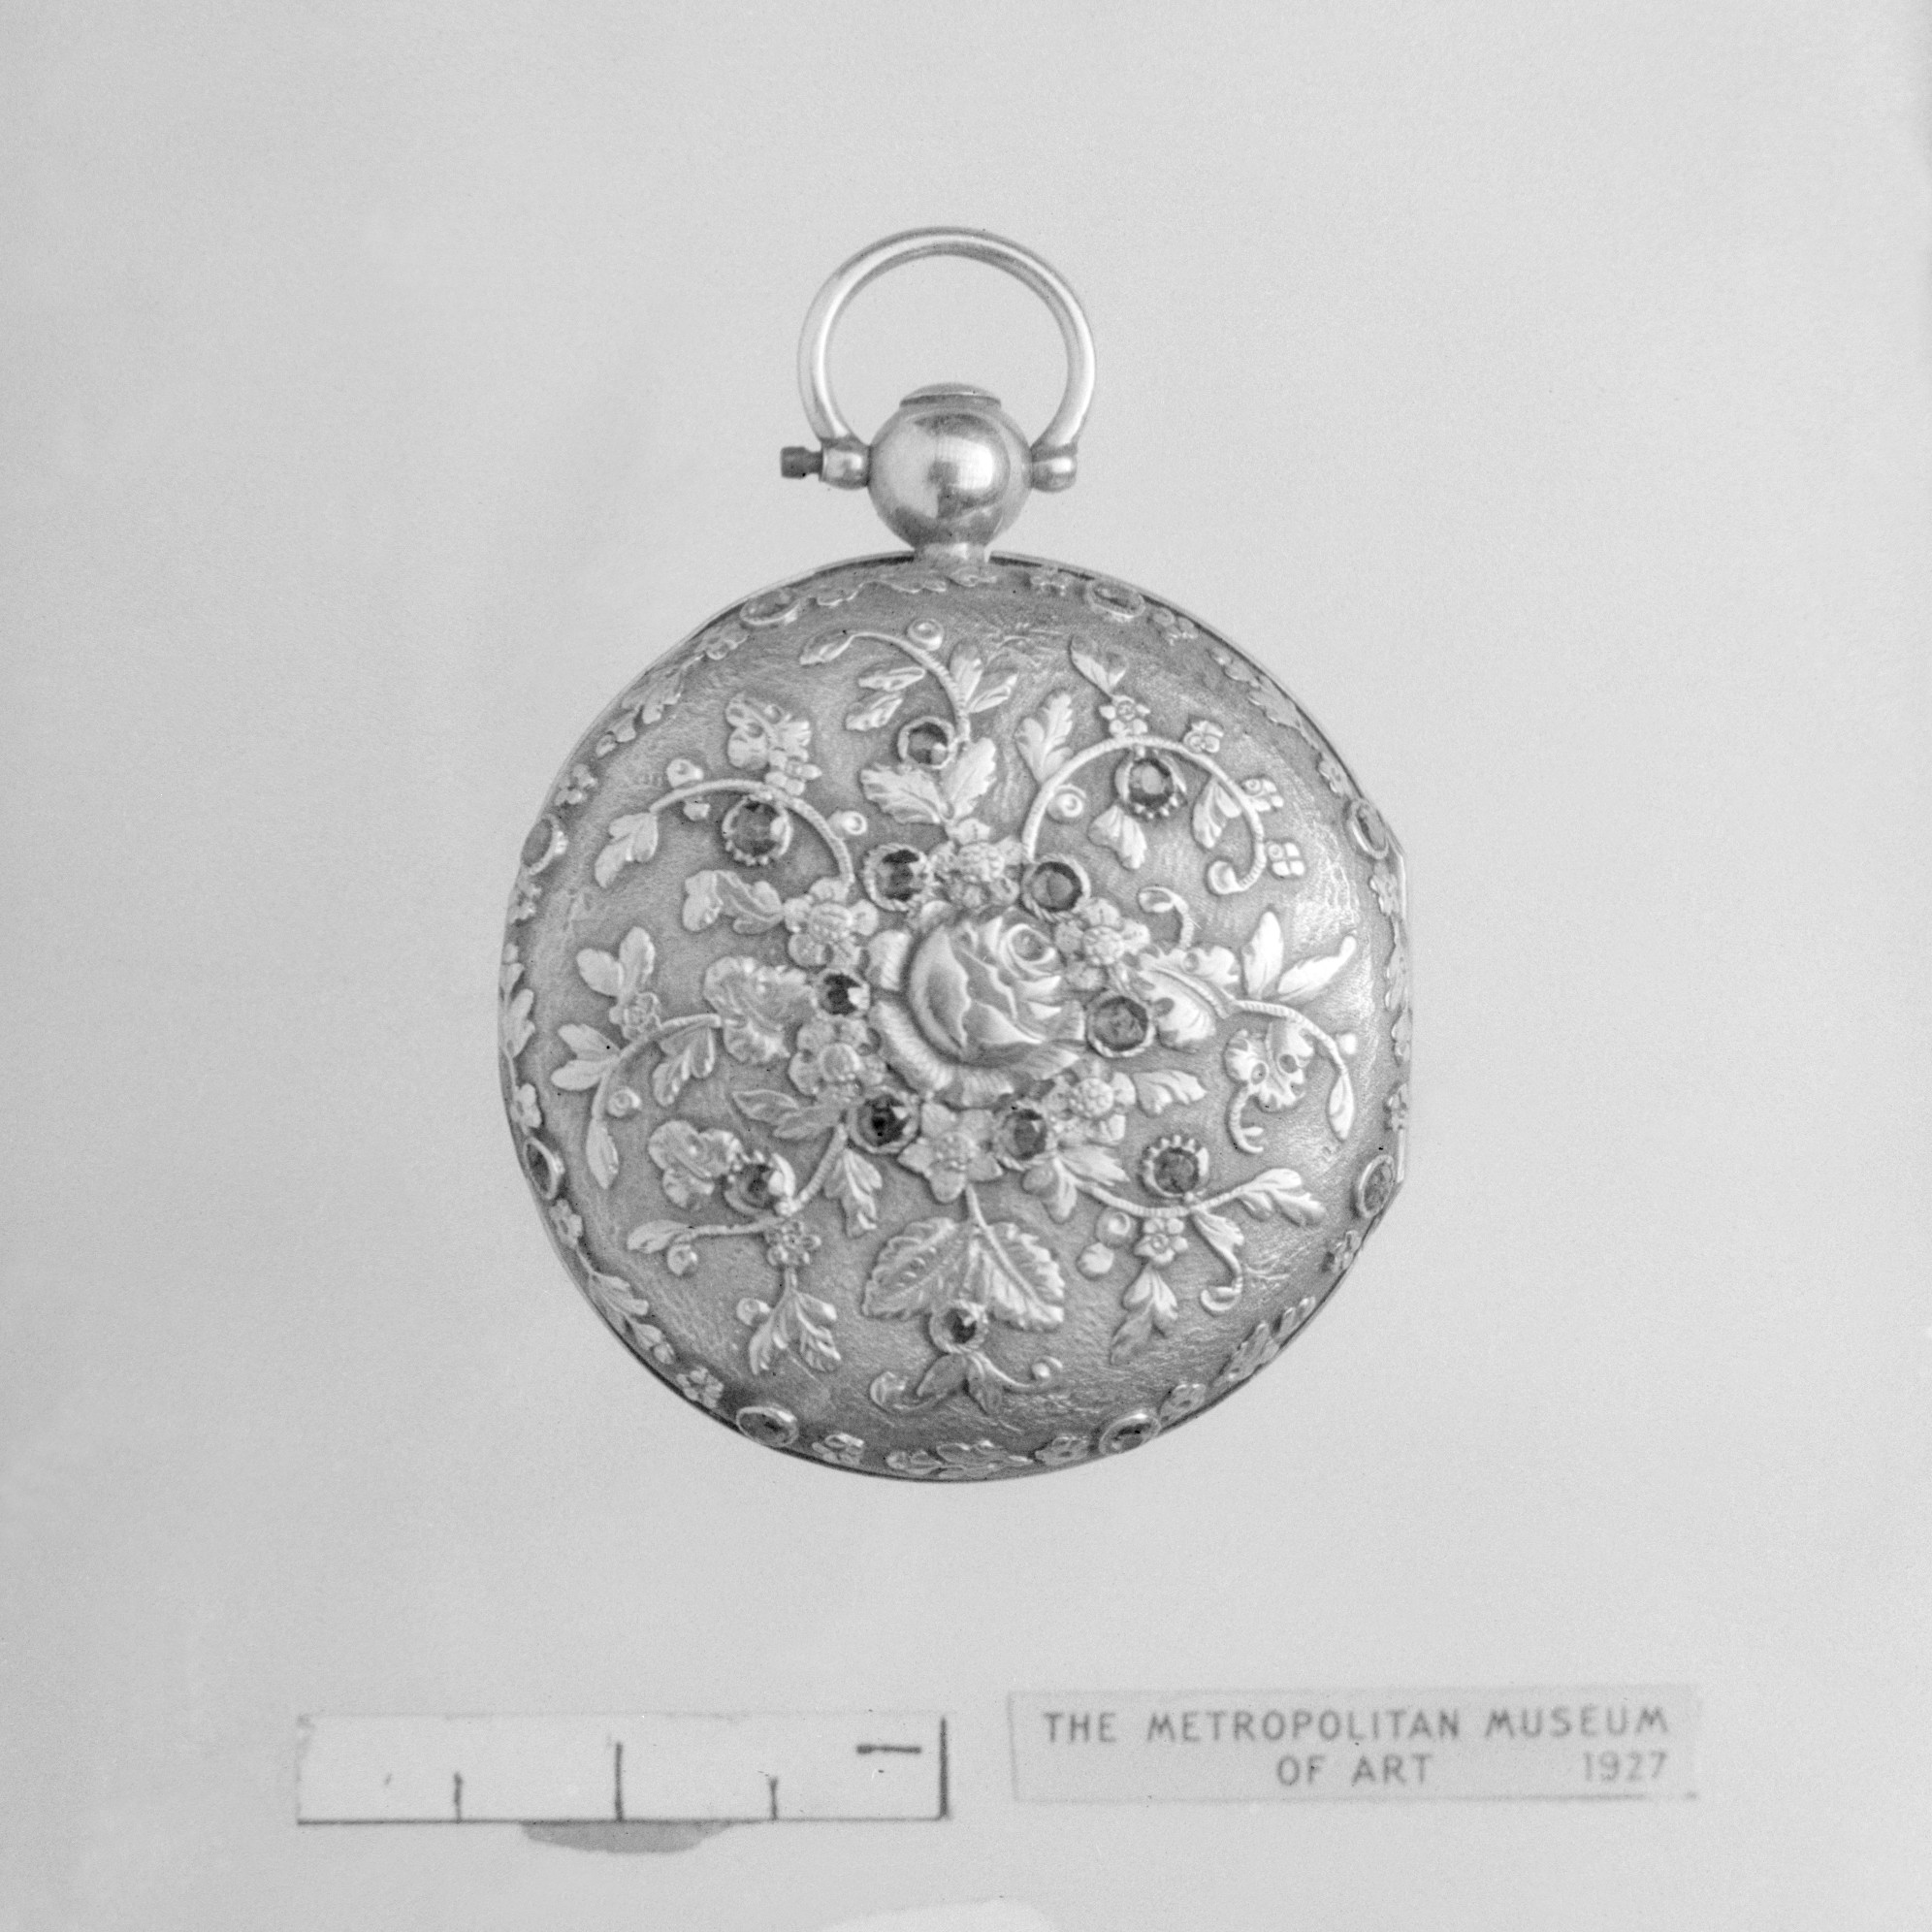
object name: watch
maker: firm of esquivillon frères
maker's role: maker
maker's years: 1795-1805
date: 1800-1830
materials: enamel, garnet, gold, steel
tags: roses,leaves